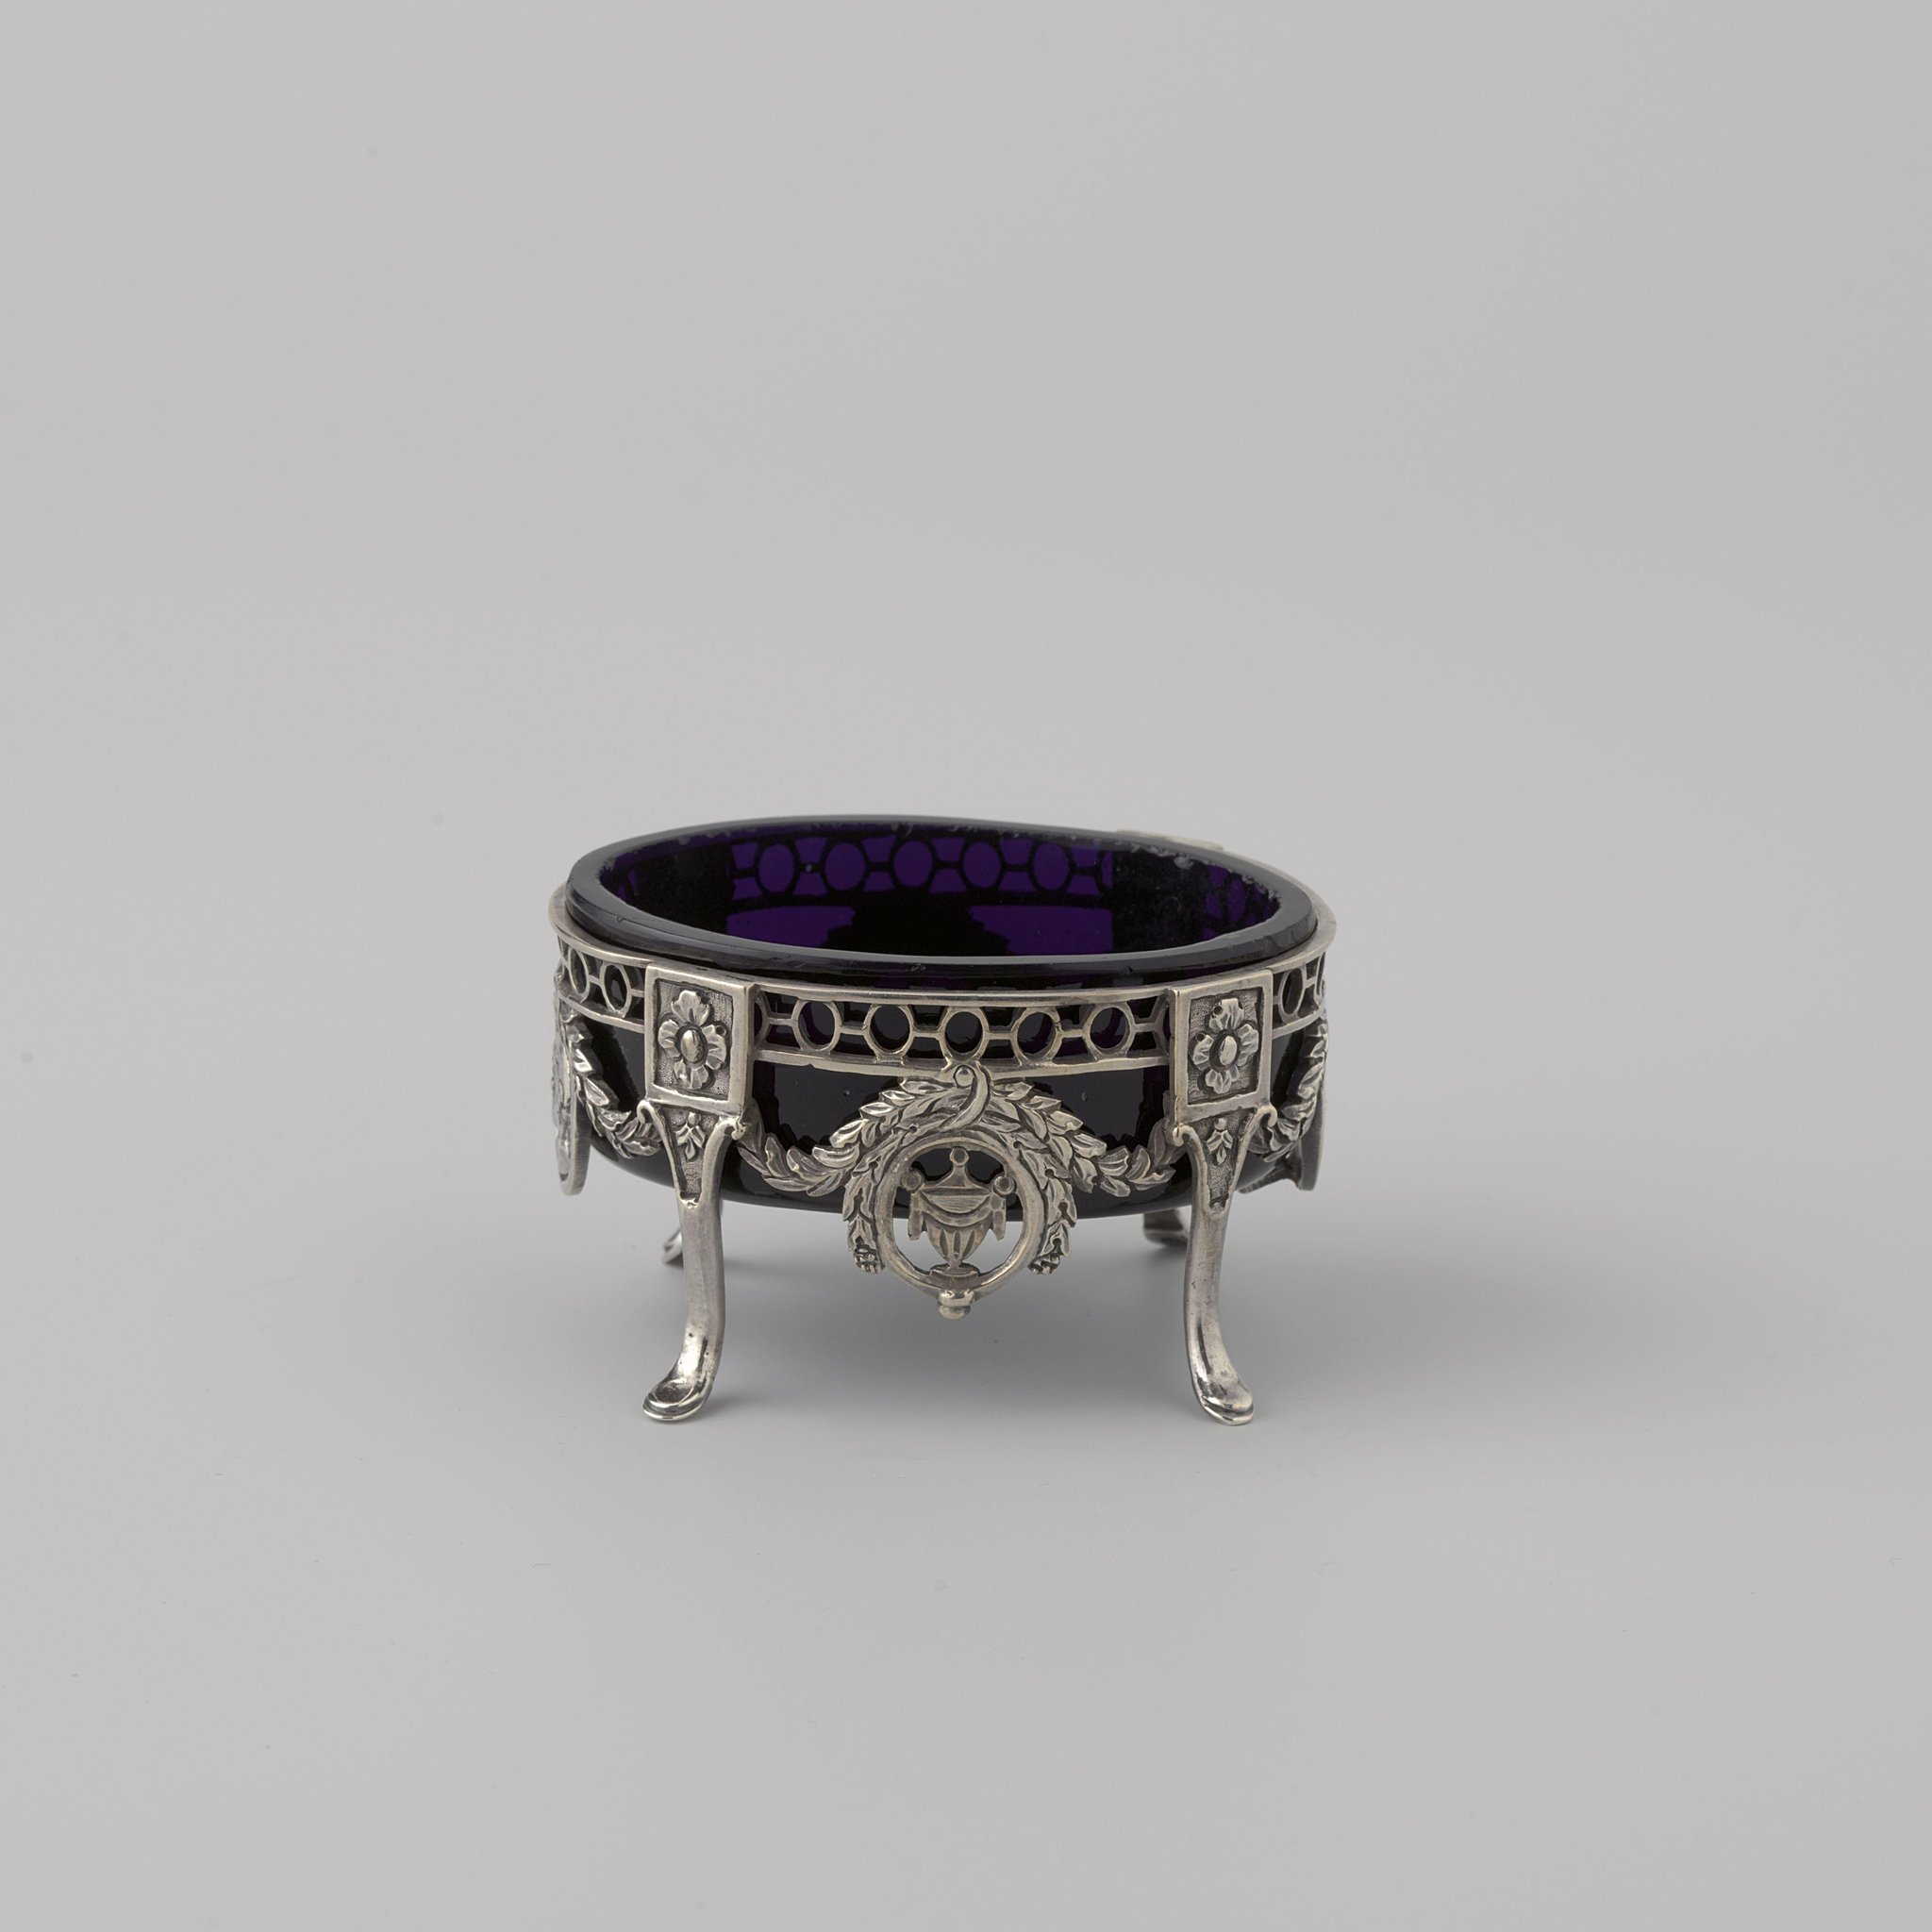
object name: salt condiment vessel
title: Zoutvat op vier poten, ovaal, met bladslingers en medaillons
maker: wouterus verschuur (zilversmid)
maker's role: silversmith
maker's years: 1756-1828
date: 1790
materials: glass, silver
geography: amsterdam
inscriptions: maker's mark, date letter: ‘F’, town mark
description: De ovale zilveren houders (A en B) met blauw glazen binnenbak rusten op vier gebogen pootjes, die elk op een voetje staan. De pootjes lopen naar boven breed uit en zijn daar in een uitgronding versierd met bladmotieven op een geruwde grond. Elk pootje draagt een rechthoekig huis met in een uitgronding een rozet op een geruwde grond. De huizen zijn bevestigd tegen een met onderling verbonden ovalen opengezaagde galerij die de bovenrand van de houder vormt. Hier zijn met ringen bladslingers en medaillons aan gehangen, aan voor- en achterzijde een medaillon met een vaas, aan beide zijkanten een medaillon met een gelauwerde manskop in profiel. Aan de achterzijde van de beide portretmedaillons bevindt zich een lipje waarop de binnenbak rust (bij B is een lipje afgebroken). De binnenbak vertoont aan de onderzijde een geslepen stermotief.